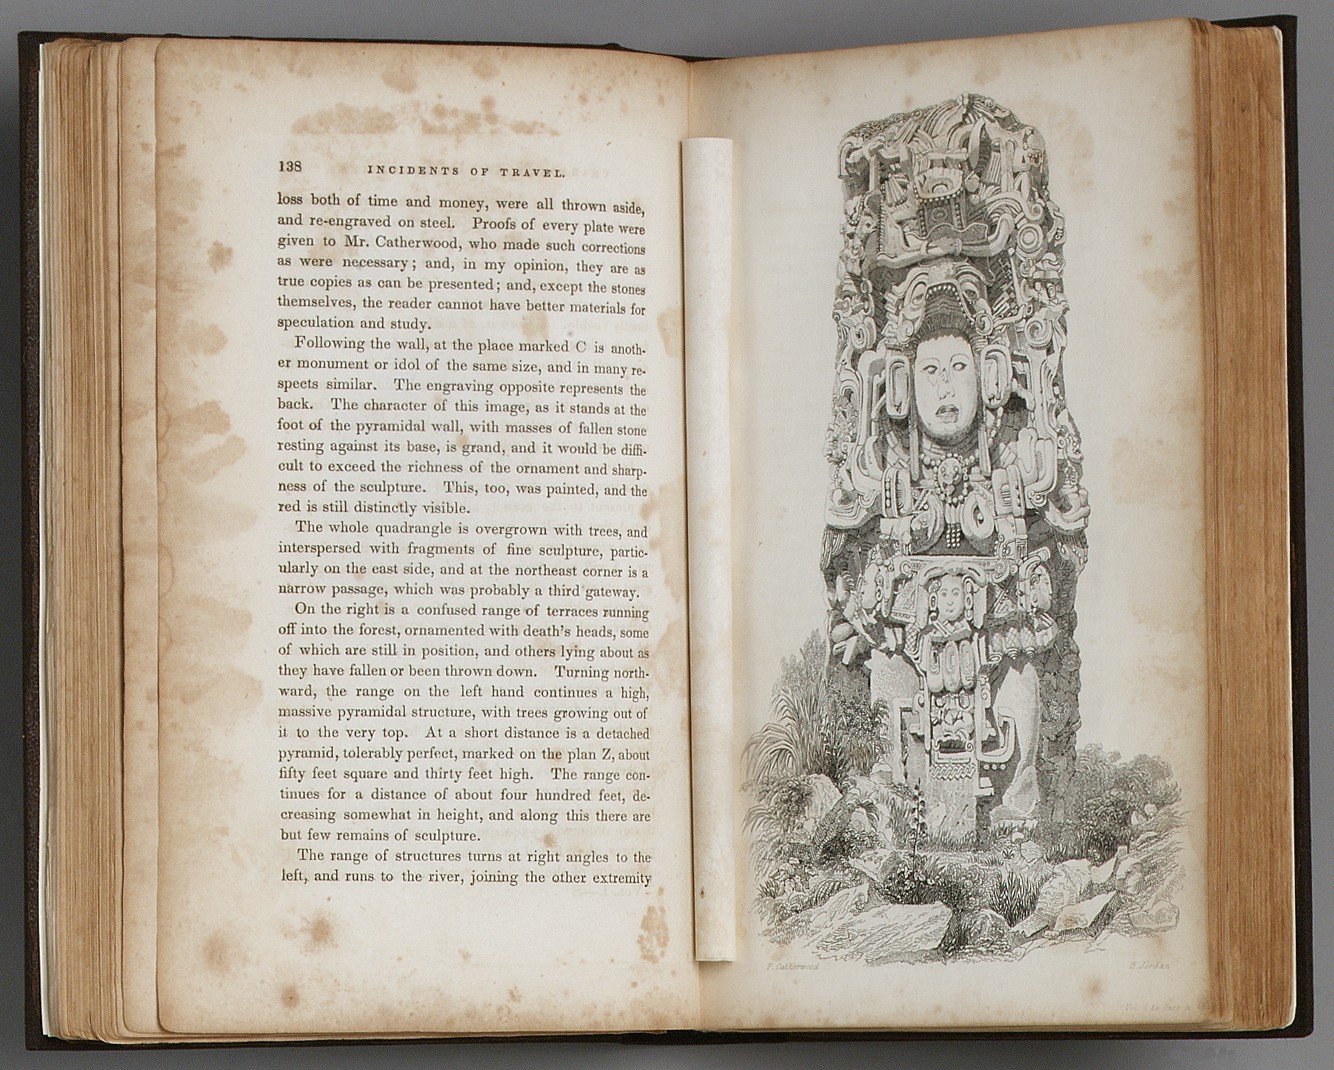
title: Incidents of Travel in Central America, Chiapas, and Yucatan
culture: british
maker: john lloyd stephens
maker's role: author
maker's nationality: american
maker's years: 1805-1852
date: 1842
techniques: printing